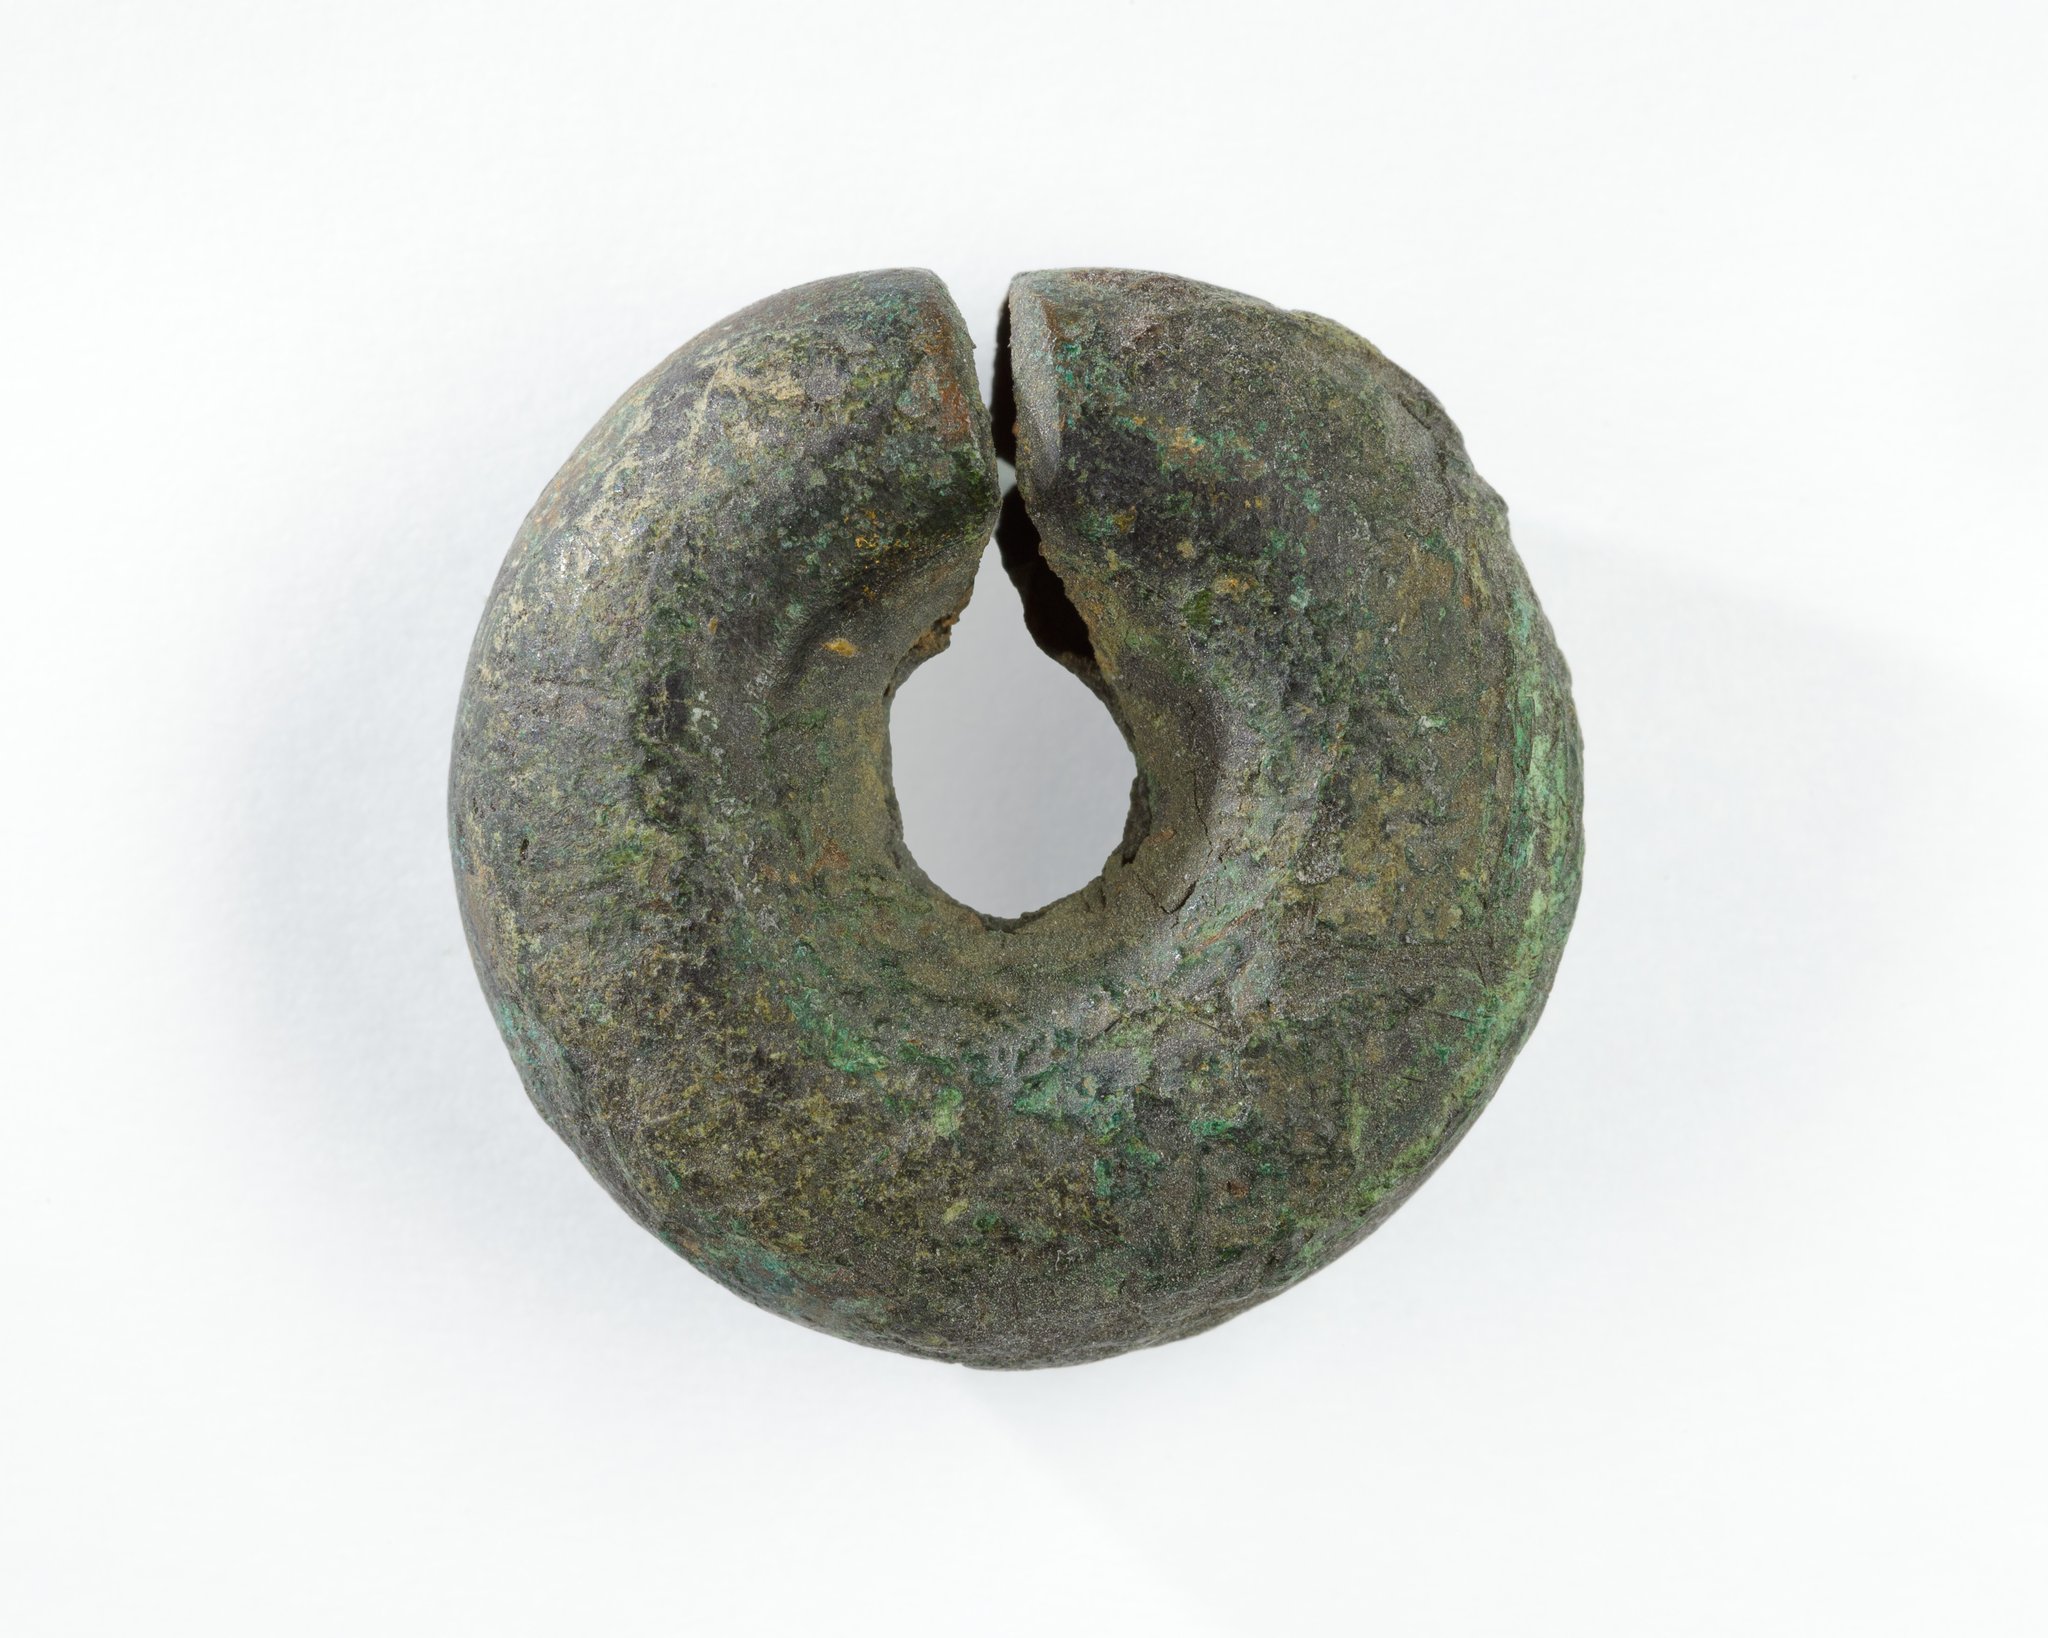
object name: earring, penannular, circular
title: Penannular Earring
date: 1550-1295 BCE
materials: copper alloy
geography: northern upper egypt